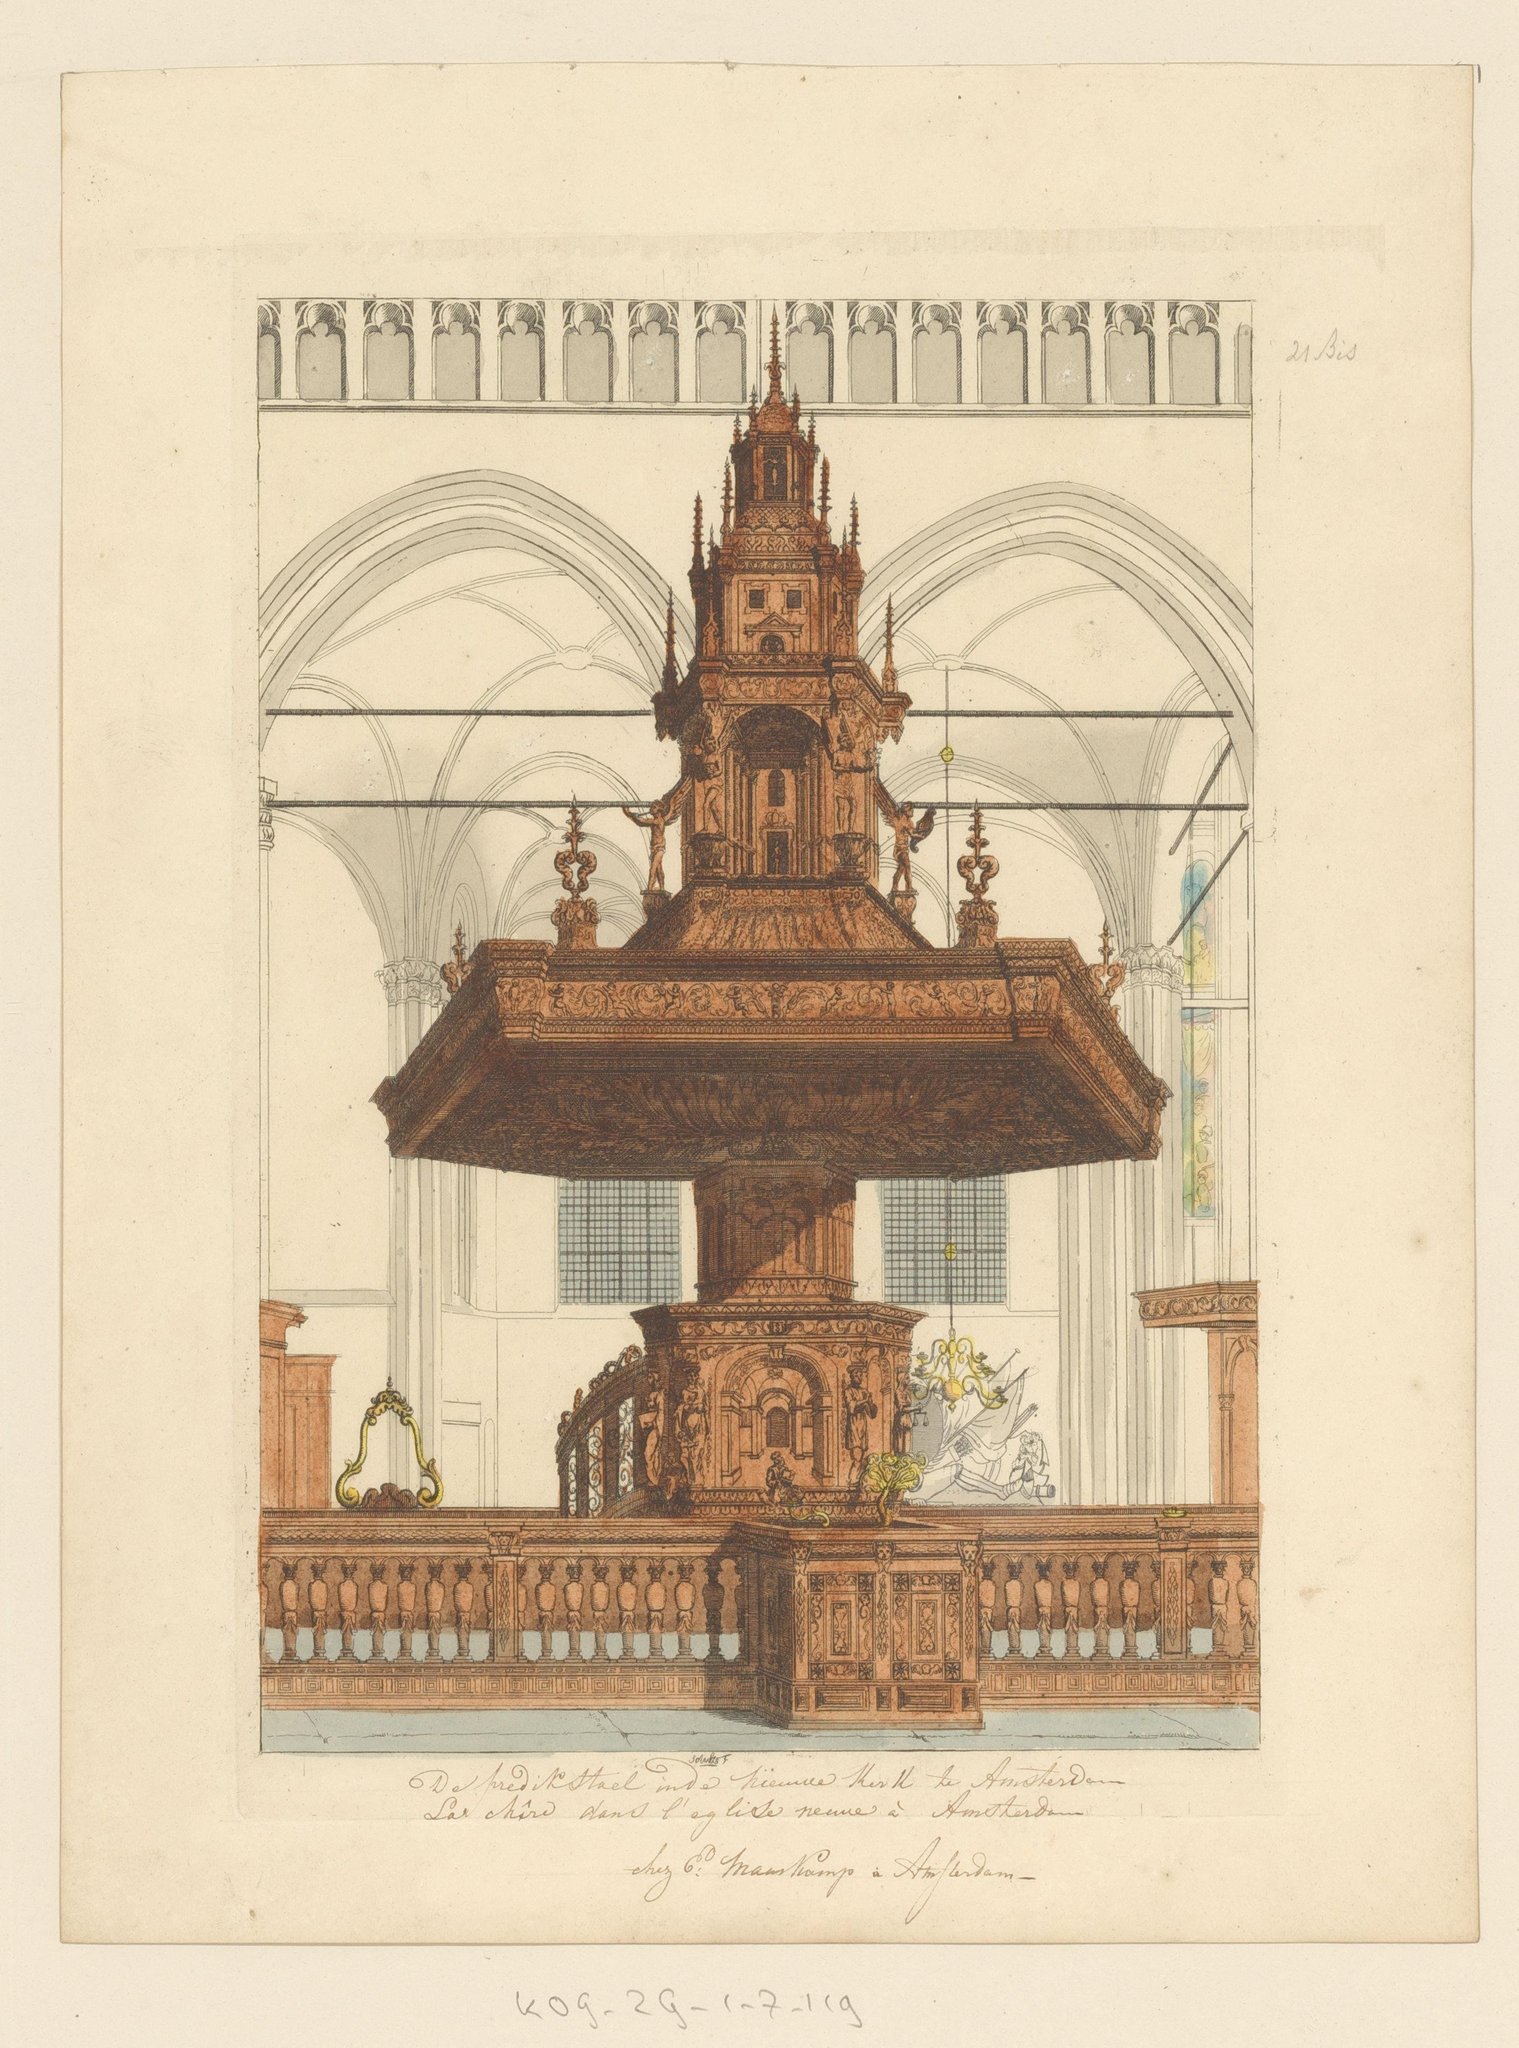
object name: print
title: Preekstoel in de Nieuwe Kerk in Amsterdam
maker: willem schults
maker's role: print maker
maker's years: 1806-1840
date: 1816-1840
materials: paper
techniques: etching, hand coloring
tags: interior of church, pulpit, ambo, chancel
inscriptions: collector's mark: Lugt 1641, stamp, stamp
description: Gezicht op de tussen 1649 en 1664 door Albert Jansz. Vinckenbrinck vervaardigde preekstoel in de Nieuwe Kerk te Amsterdam. Onderwerpsrubrieken binnen de Atlas Zeden en Gewoonten: Godsdienst, Kerkgebouwen te Amsterdam.